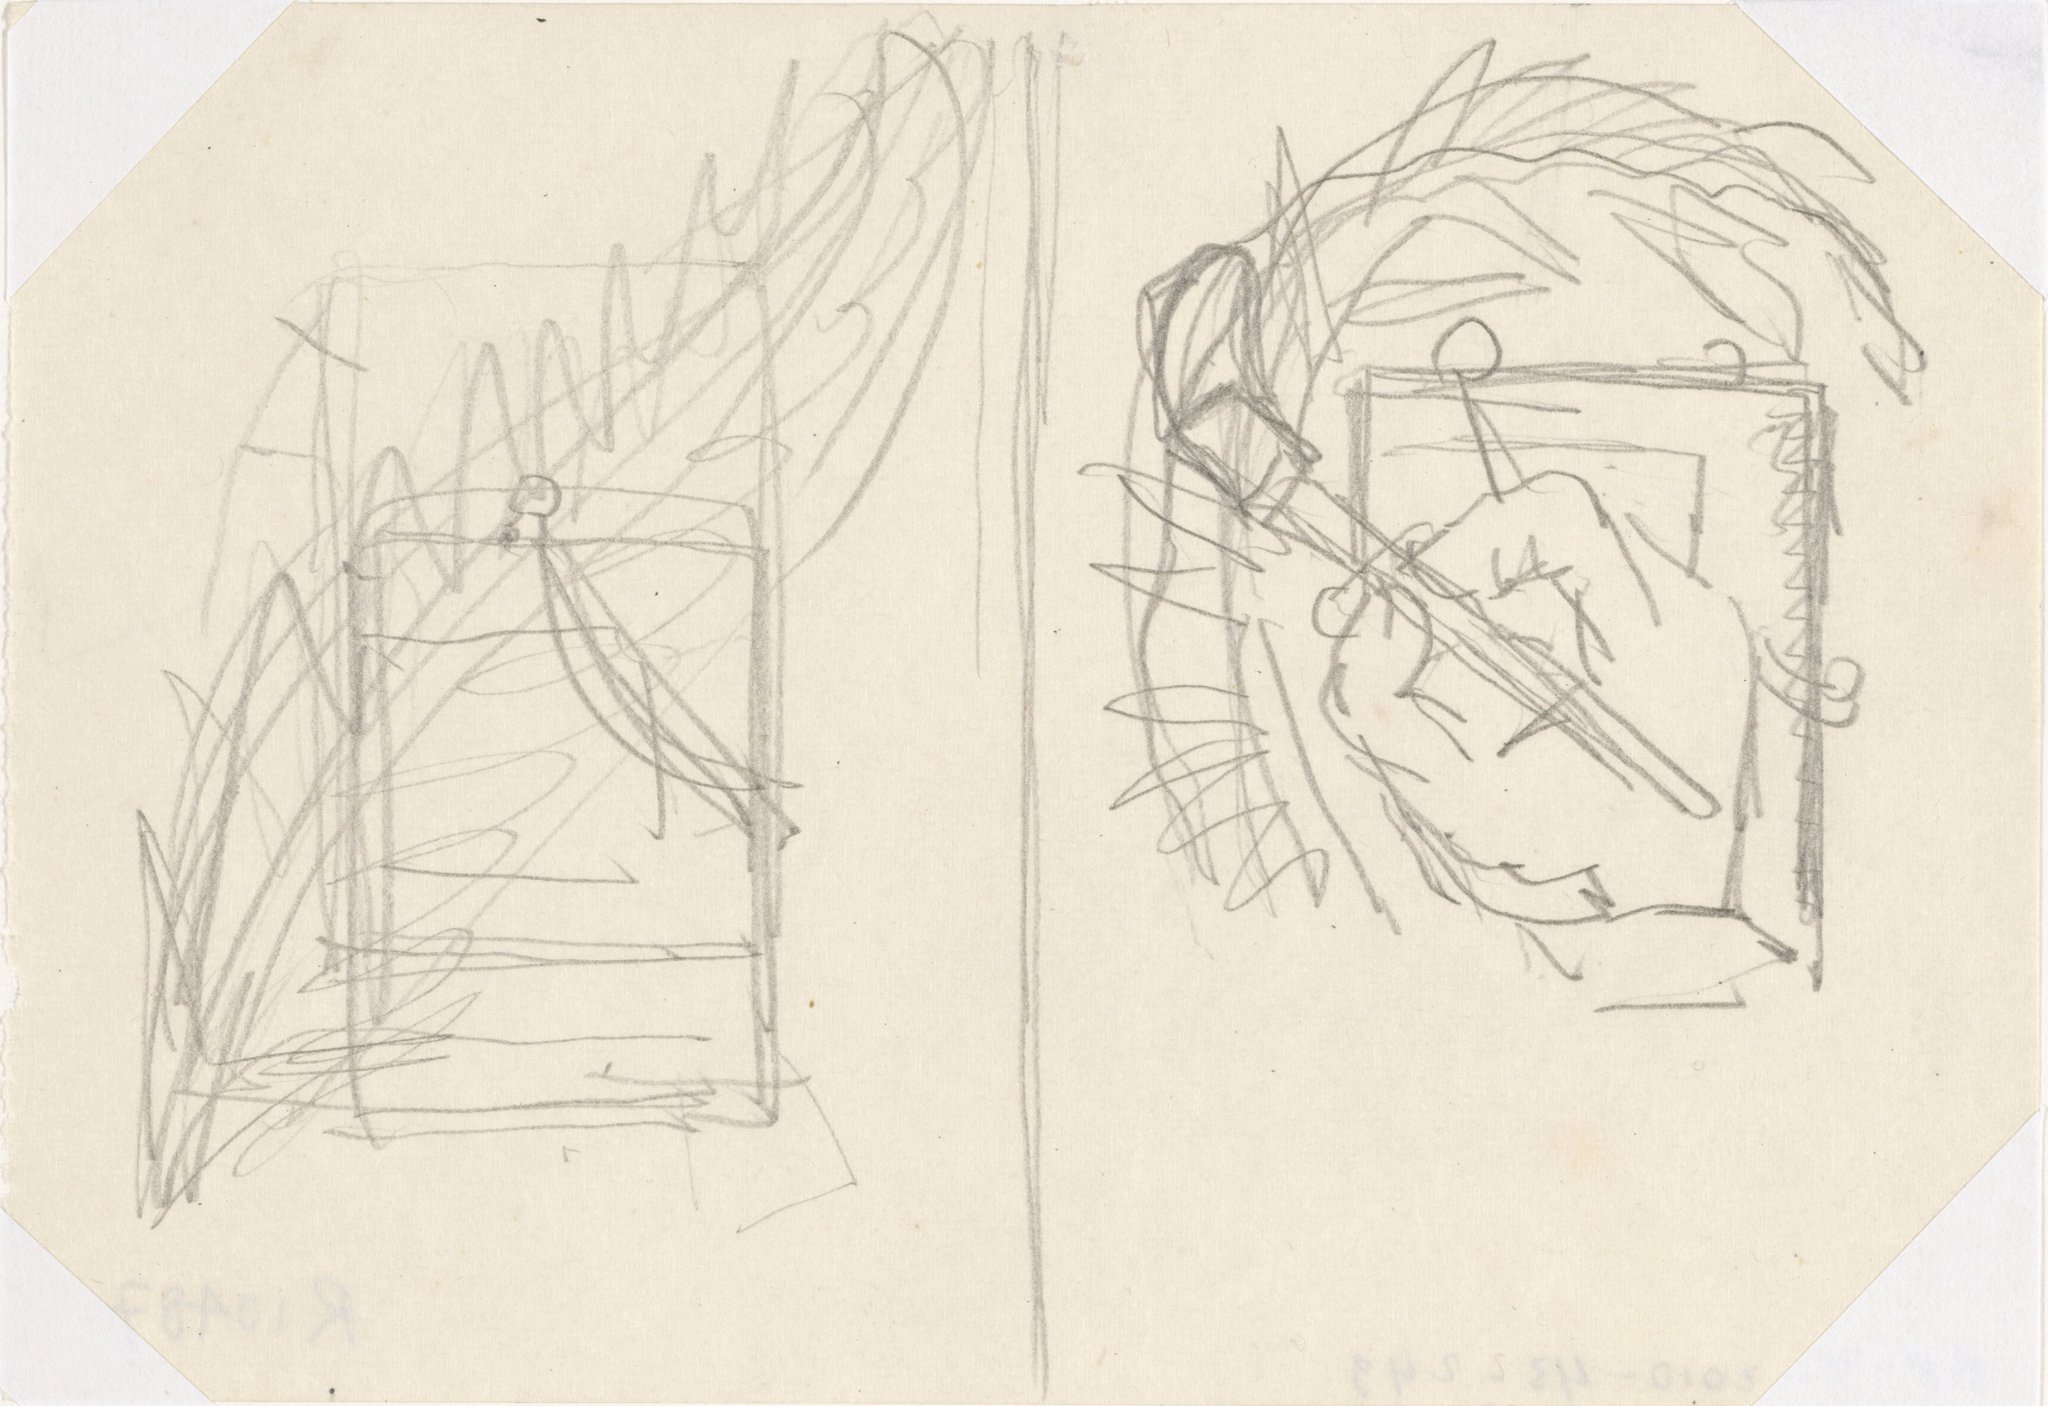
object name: drawing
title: Zonder titel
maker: leo gestel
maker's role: draughtsman, print maker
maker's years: 1881-1941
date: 1931-1941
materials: paper, pencil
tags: painting (including book-illumination, miniature-painting)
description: Blad in tweeën gedeeld door verticale streep, waarvan links een hand met penseel. Ontwerp voor het Maandblad Verf en Kunst van P.A. Regnault.